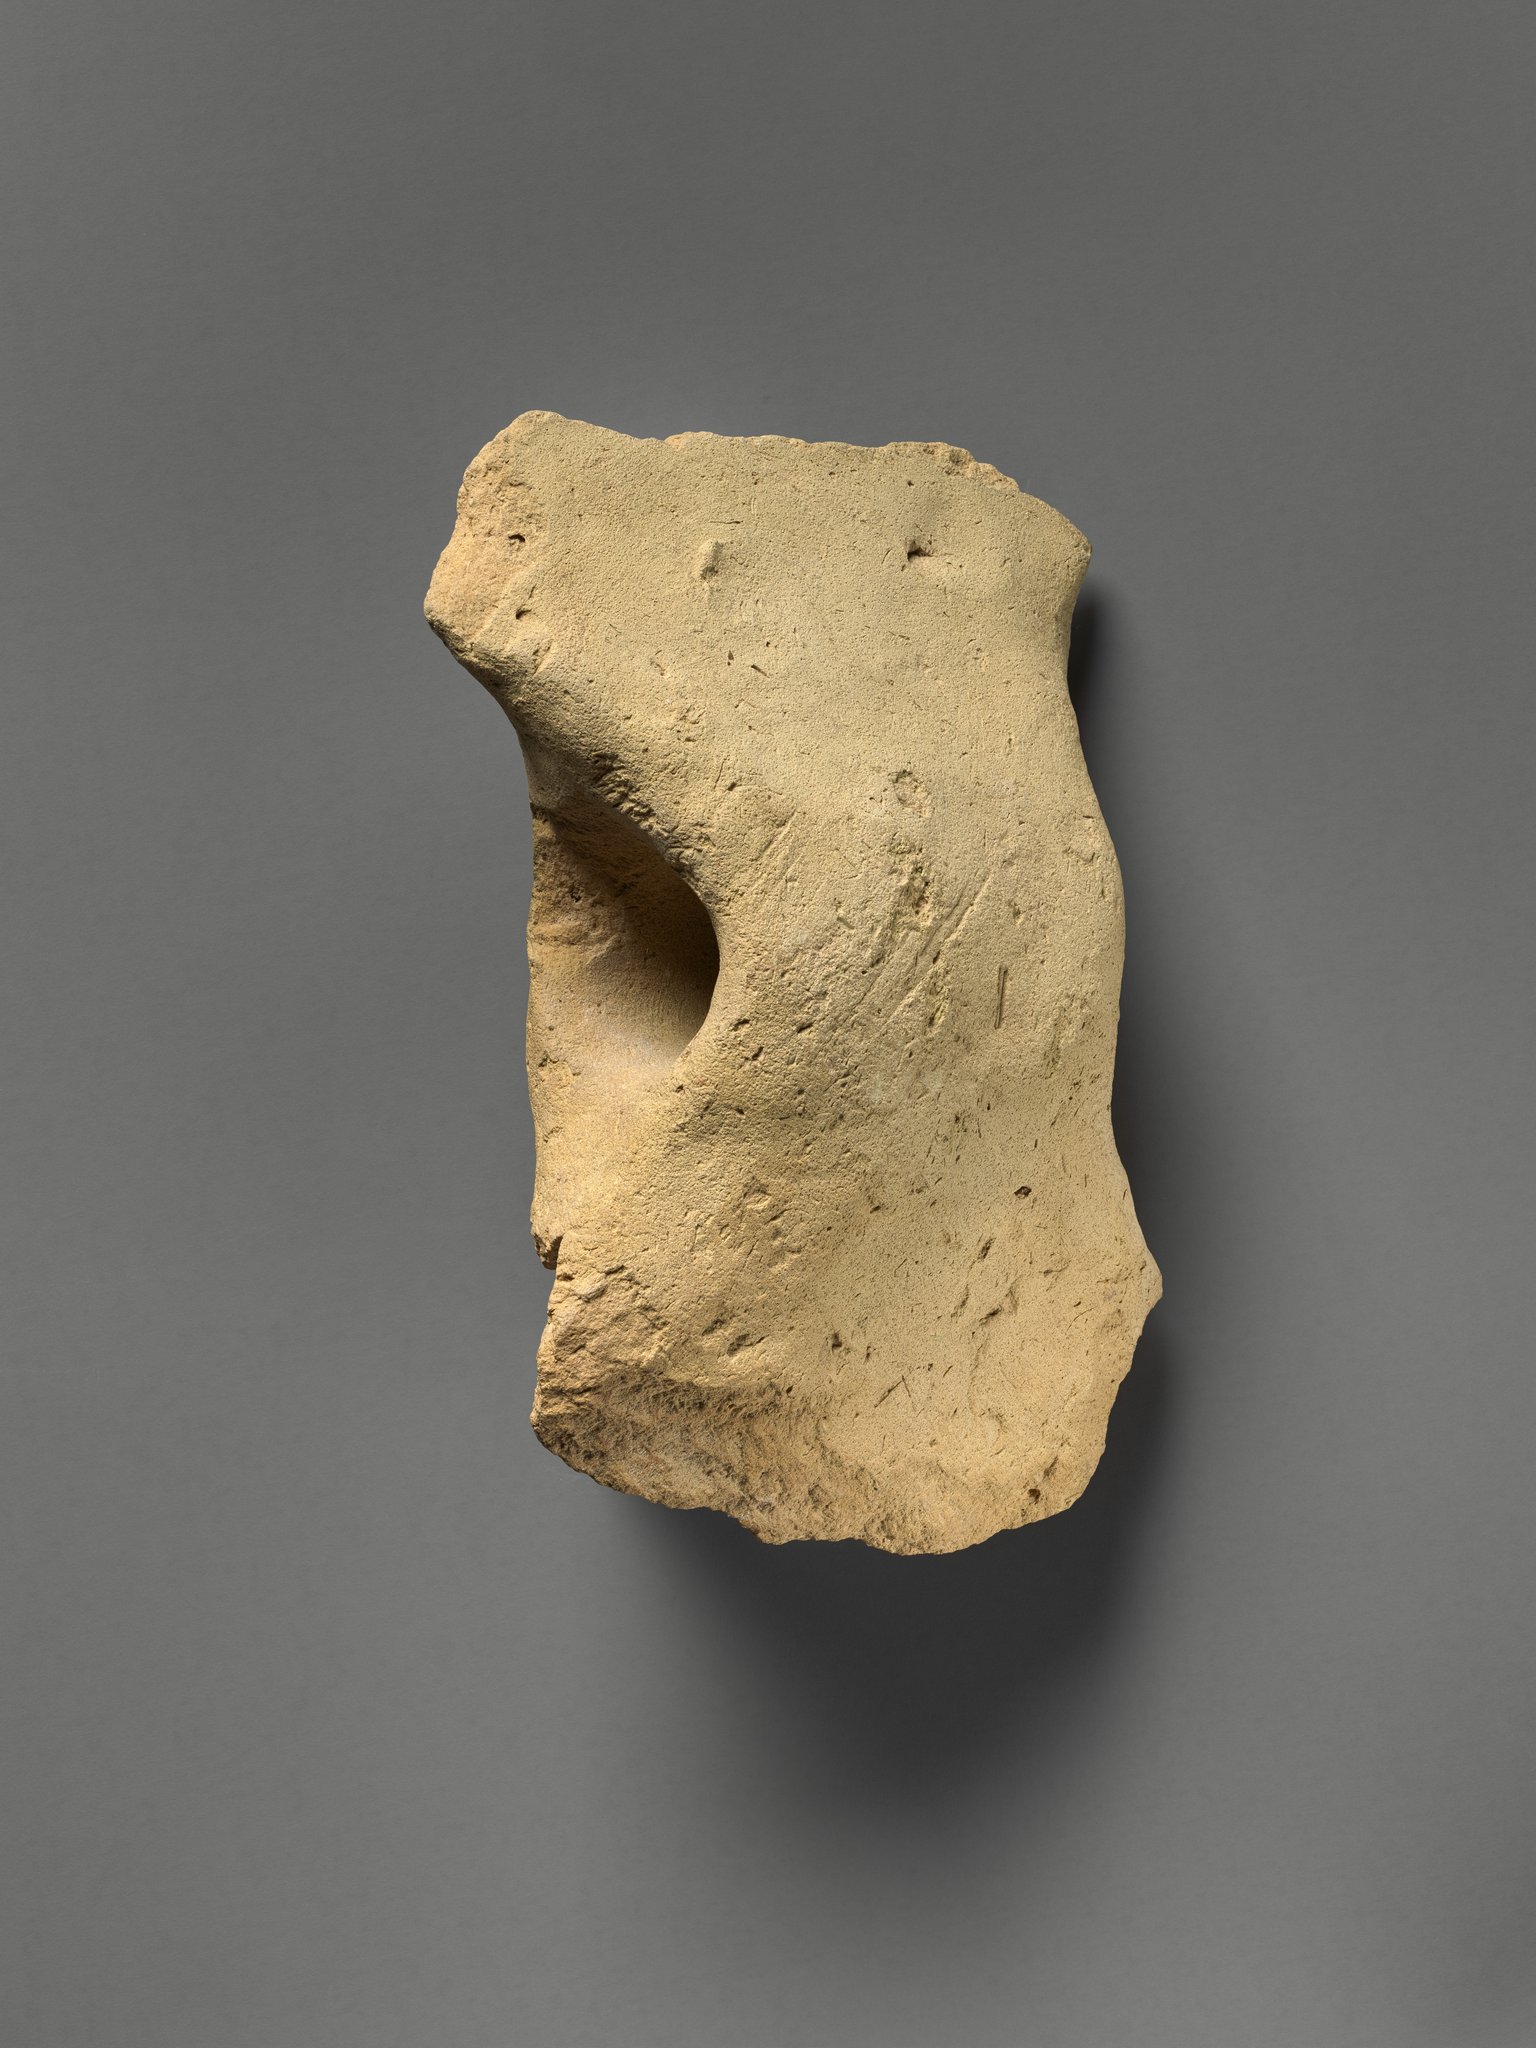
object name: axe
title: Axe head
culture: ubaid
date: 4000 BCE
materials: ceramic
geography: mesopotamia